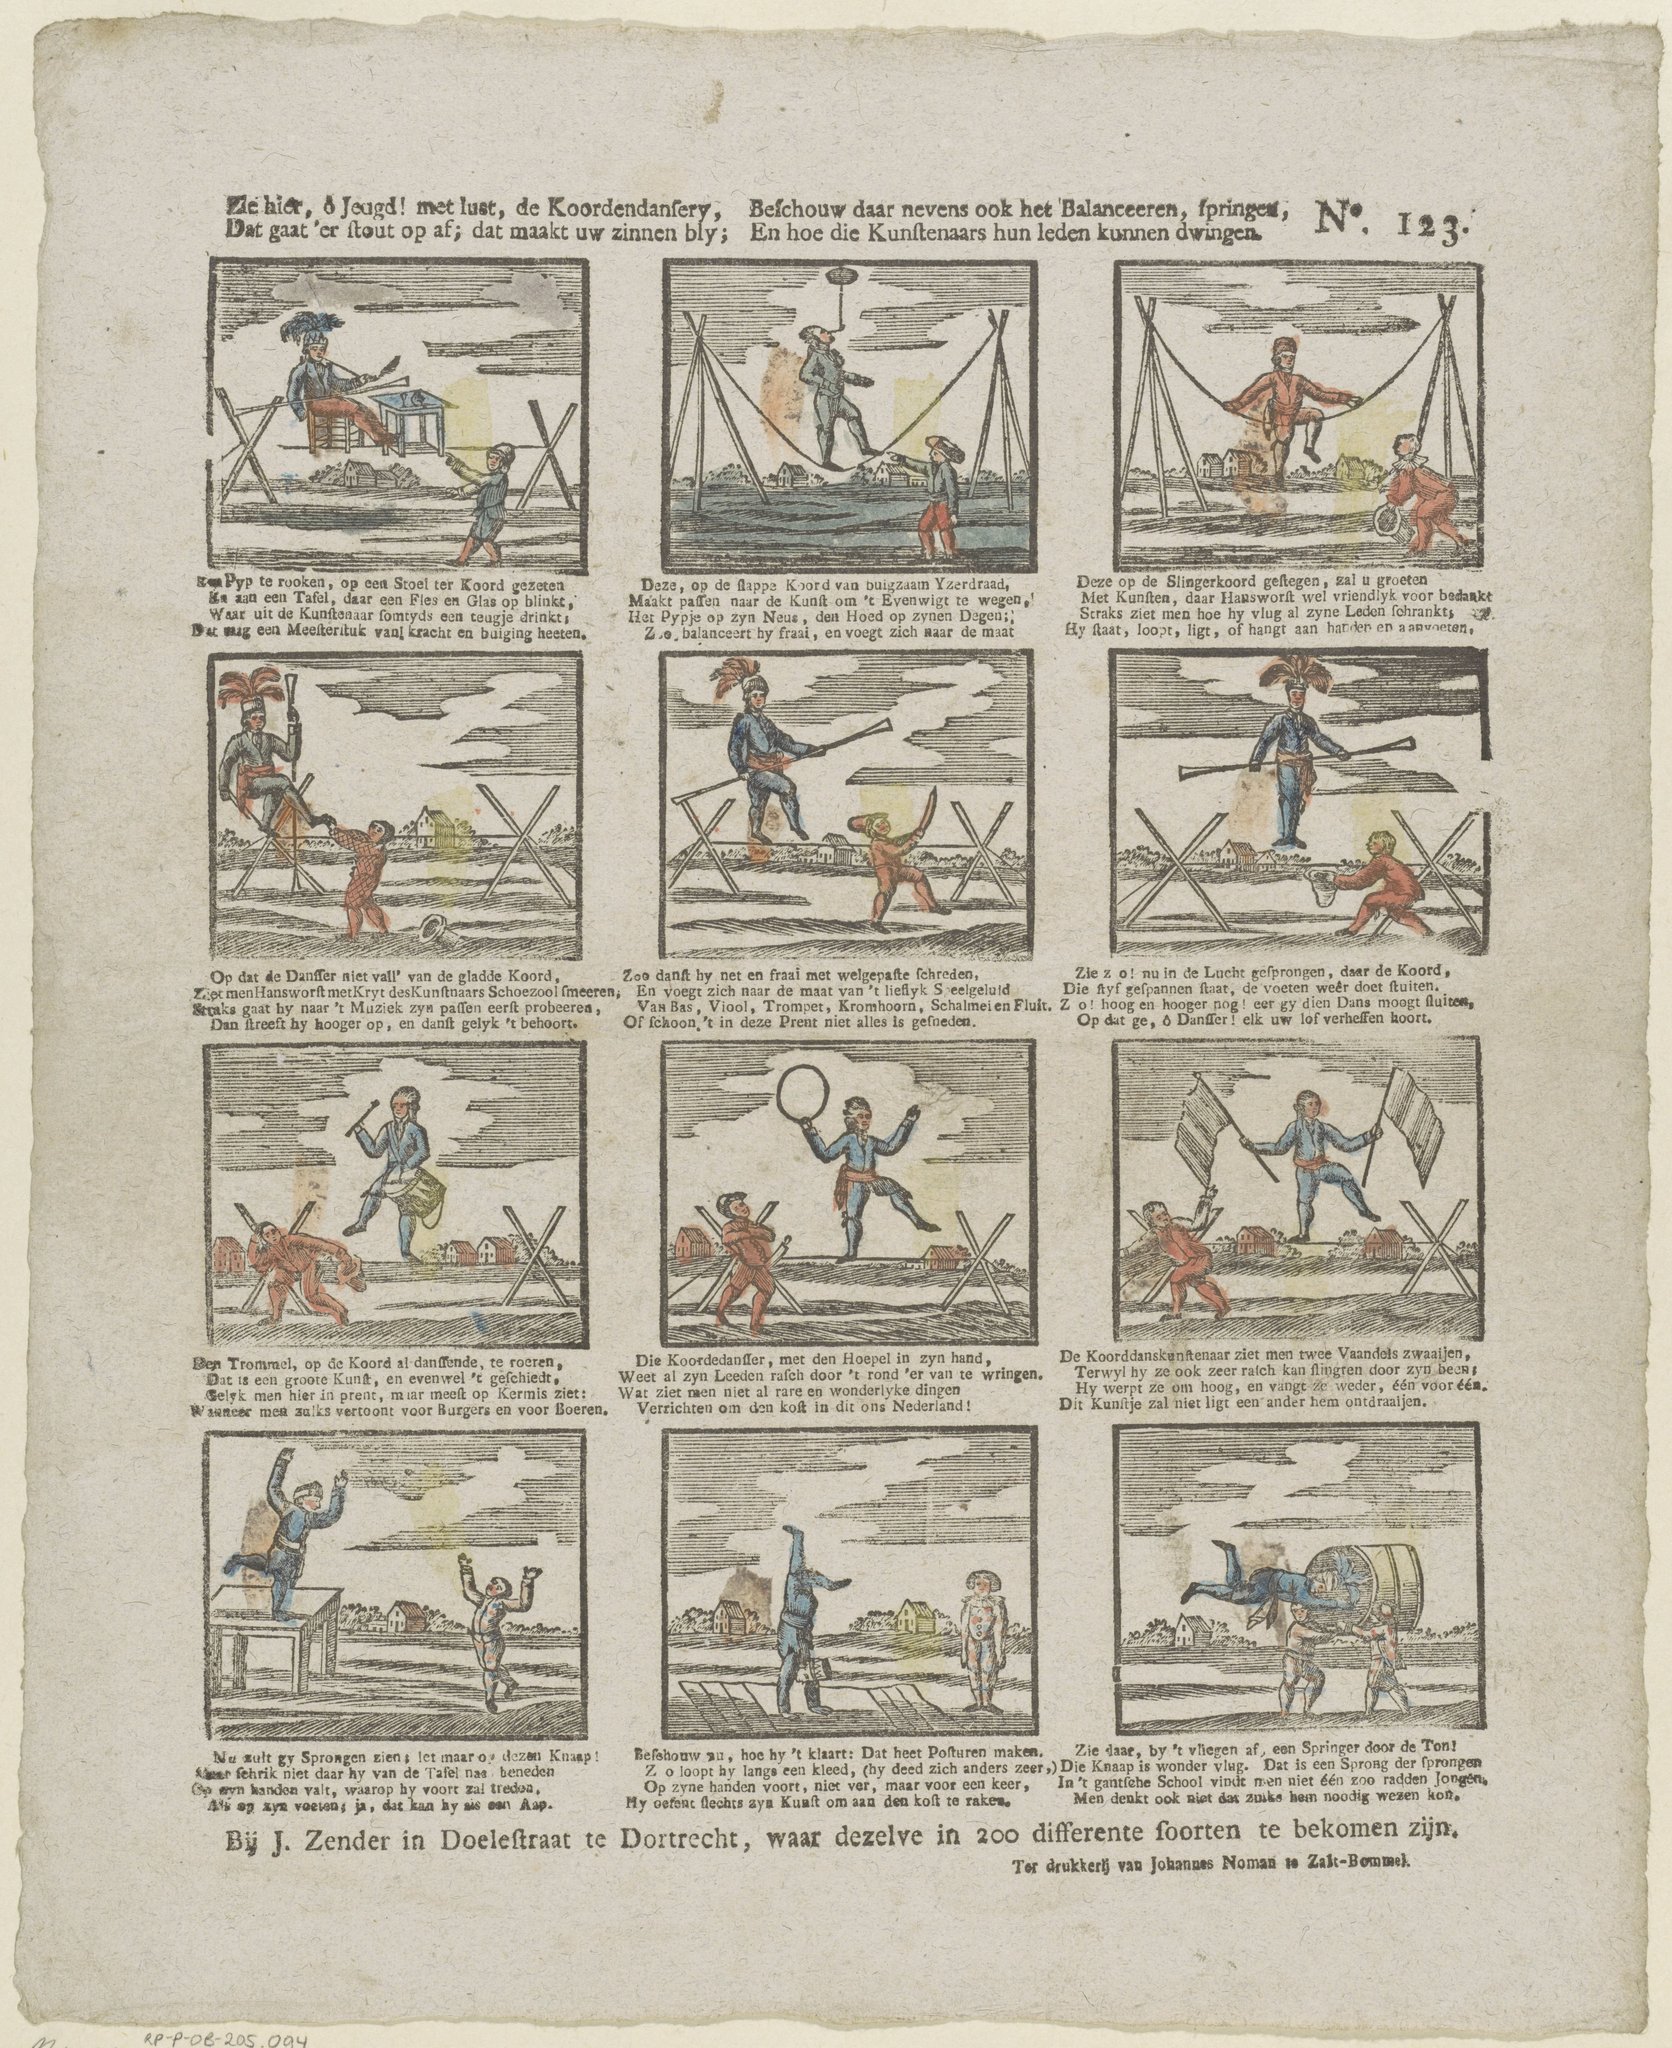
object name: popular print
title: Zie hier, ô jeugd! met lust, de koordendansery, / Dat gaat 'er stout op af; dat maakt uw zinnen bly; / Beschouw daar nevens ook het balanceeren, springen, / En hoe die kunstenaars hun leden kunnen dwingen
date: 1806-1830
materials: paper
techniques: colour, letterpress printing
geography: dordrecht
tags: equilibrist, acrobat ~ circus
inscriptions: collector's mark: Lugt 2760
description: Blad met 16 voorstellingen van circusartiesten, zoals koorddansers en acrobaten. Onder elke afbeelding een vierregelig vers. Genummerd rechtsboven: No. 123.